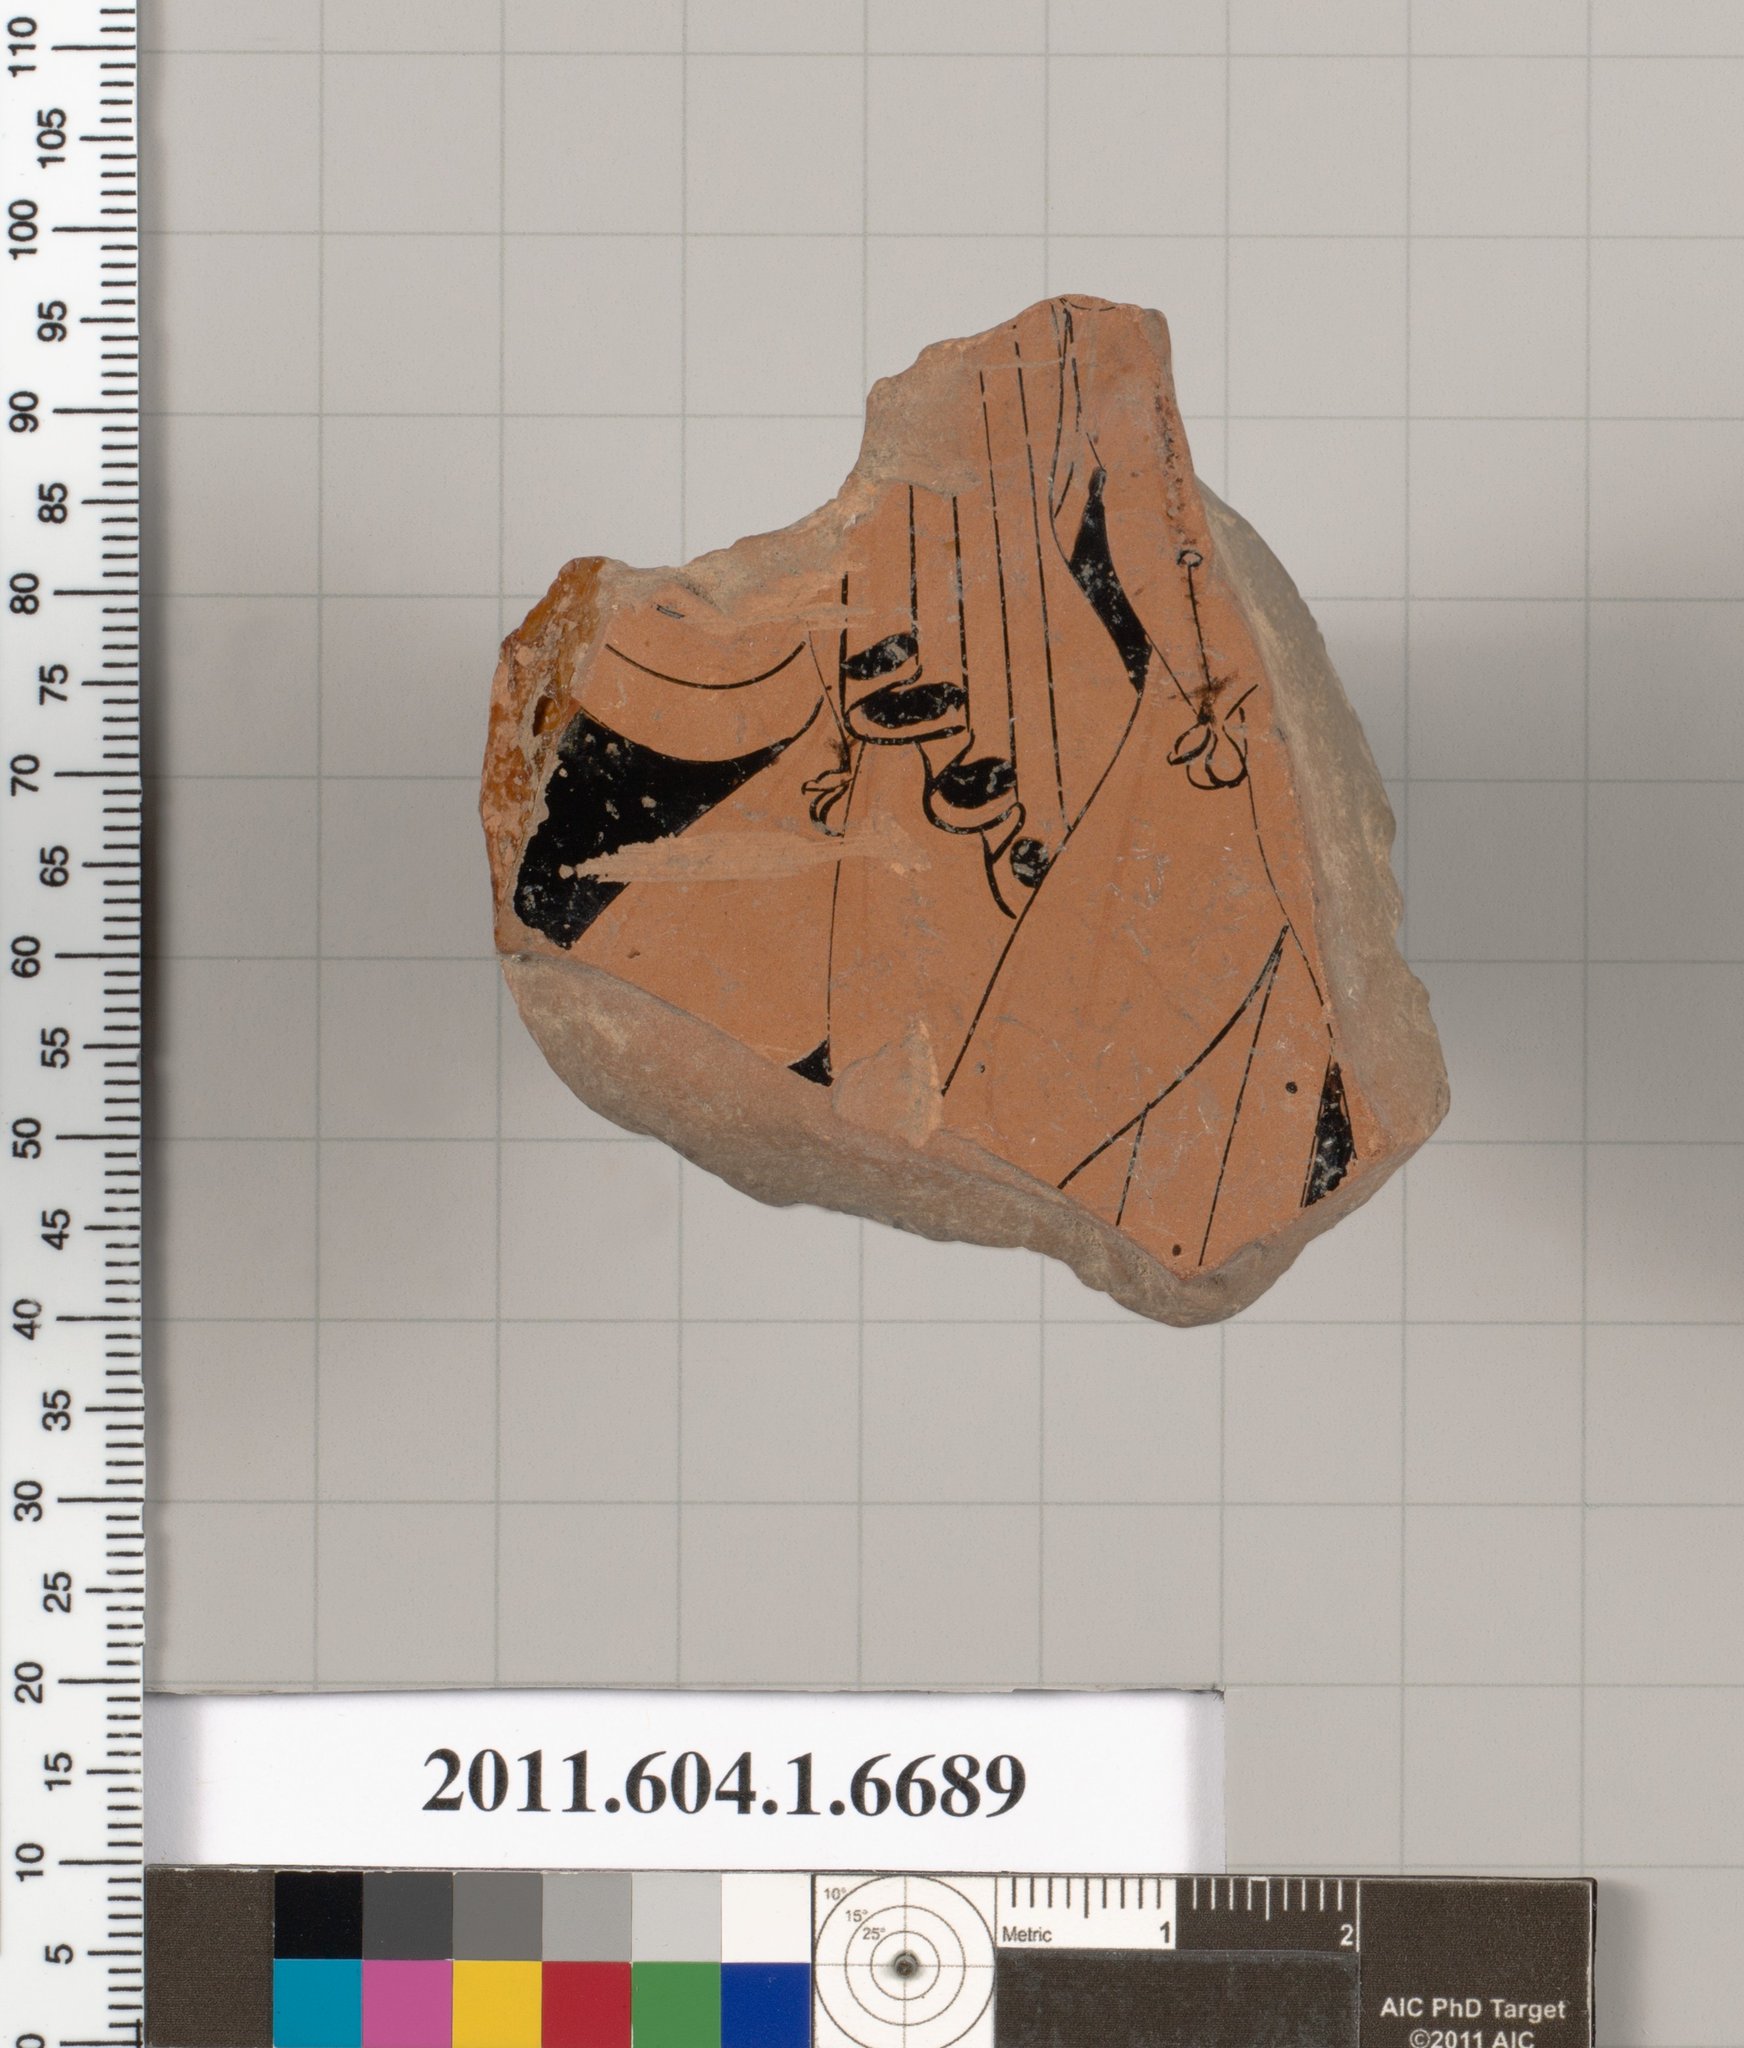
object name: kylix fragment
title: Terracotta fragment of a kylix (drinking cup)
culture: greek, attic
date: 490-470 BCE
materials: terracotta